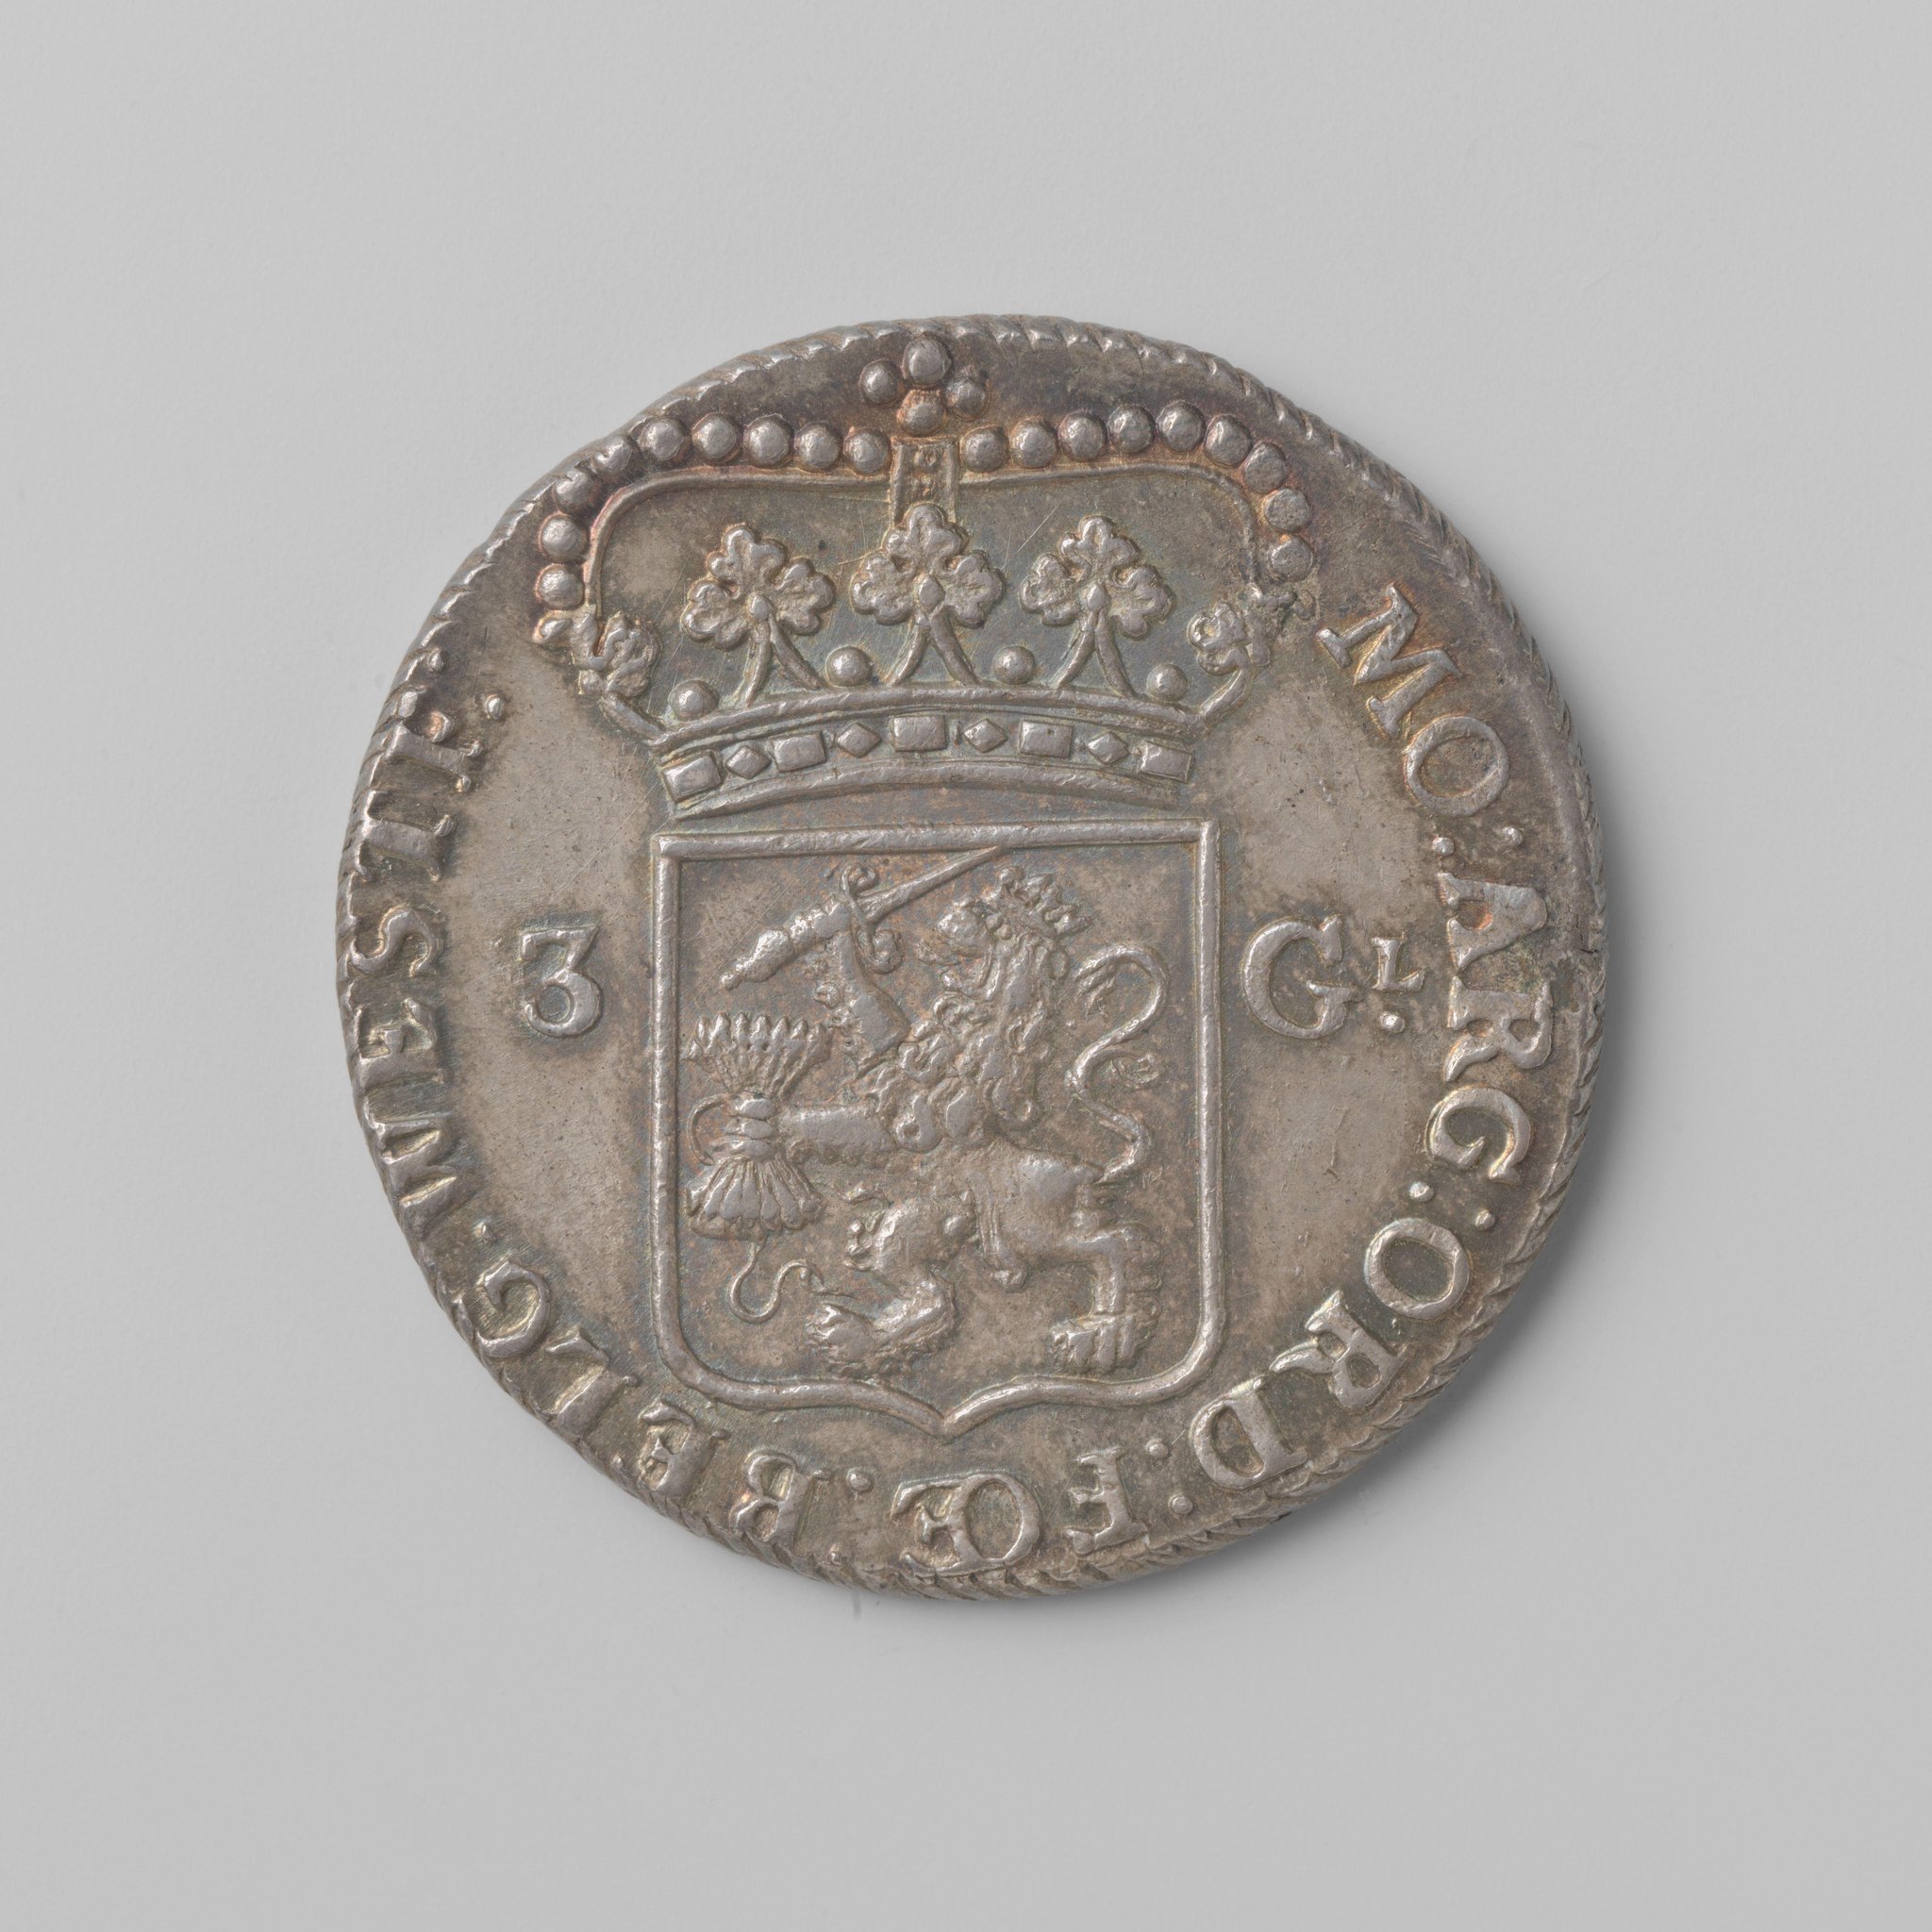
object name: coin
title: Westfriese drie gulden, 1794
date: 1794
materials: silver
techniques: striking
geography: west frisia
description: Zilveren munt. Voorzijde: tussen waarde-aanduiding gekroond generaliteitswapenschild. Keerzijde: Nederlandse maagd met vrijheidshoed en speer, leunend op een bijbel op een altaar. In afsnede jaartal. Kabelrand.